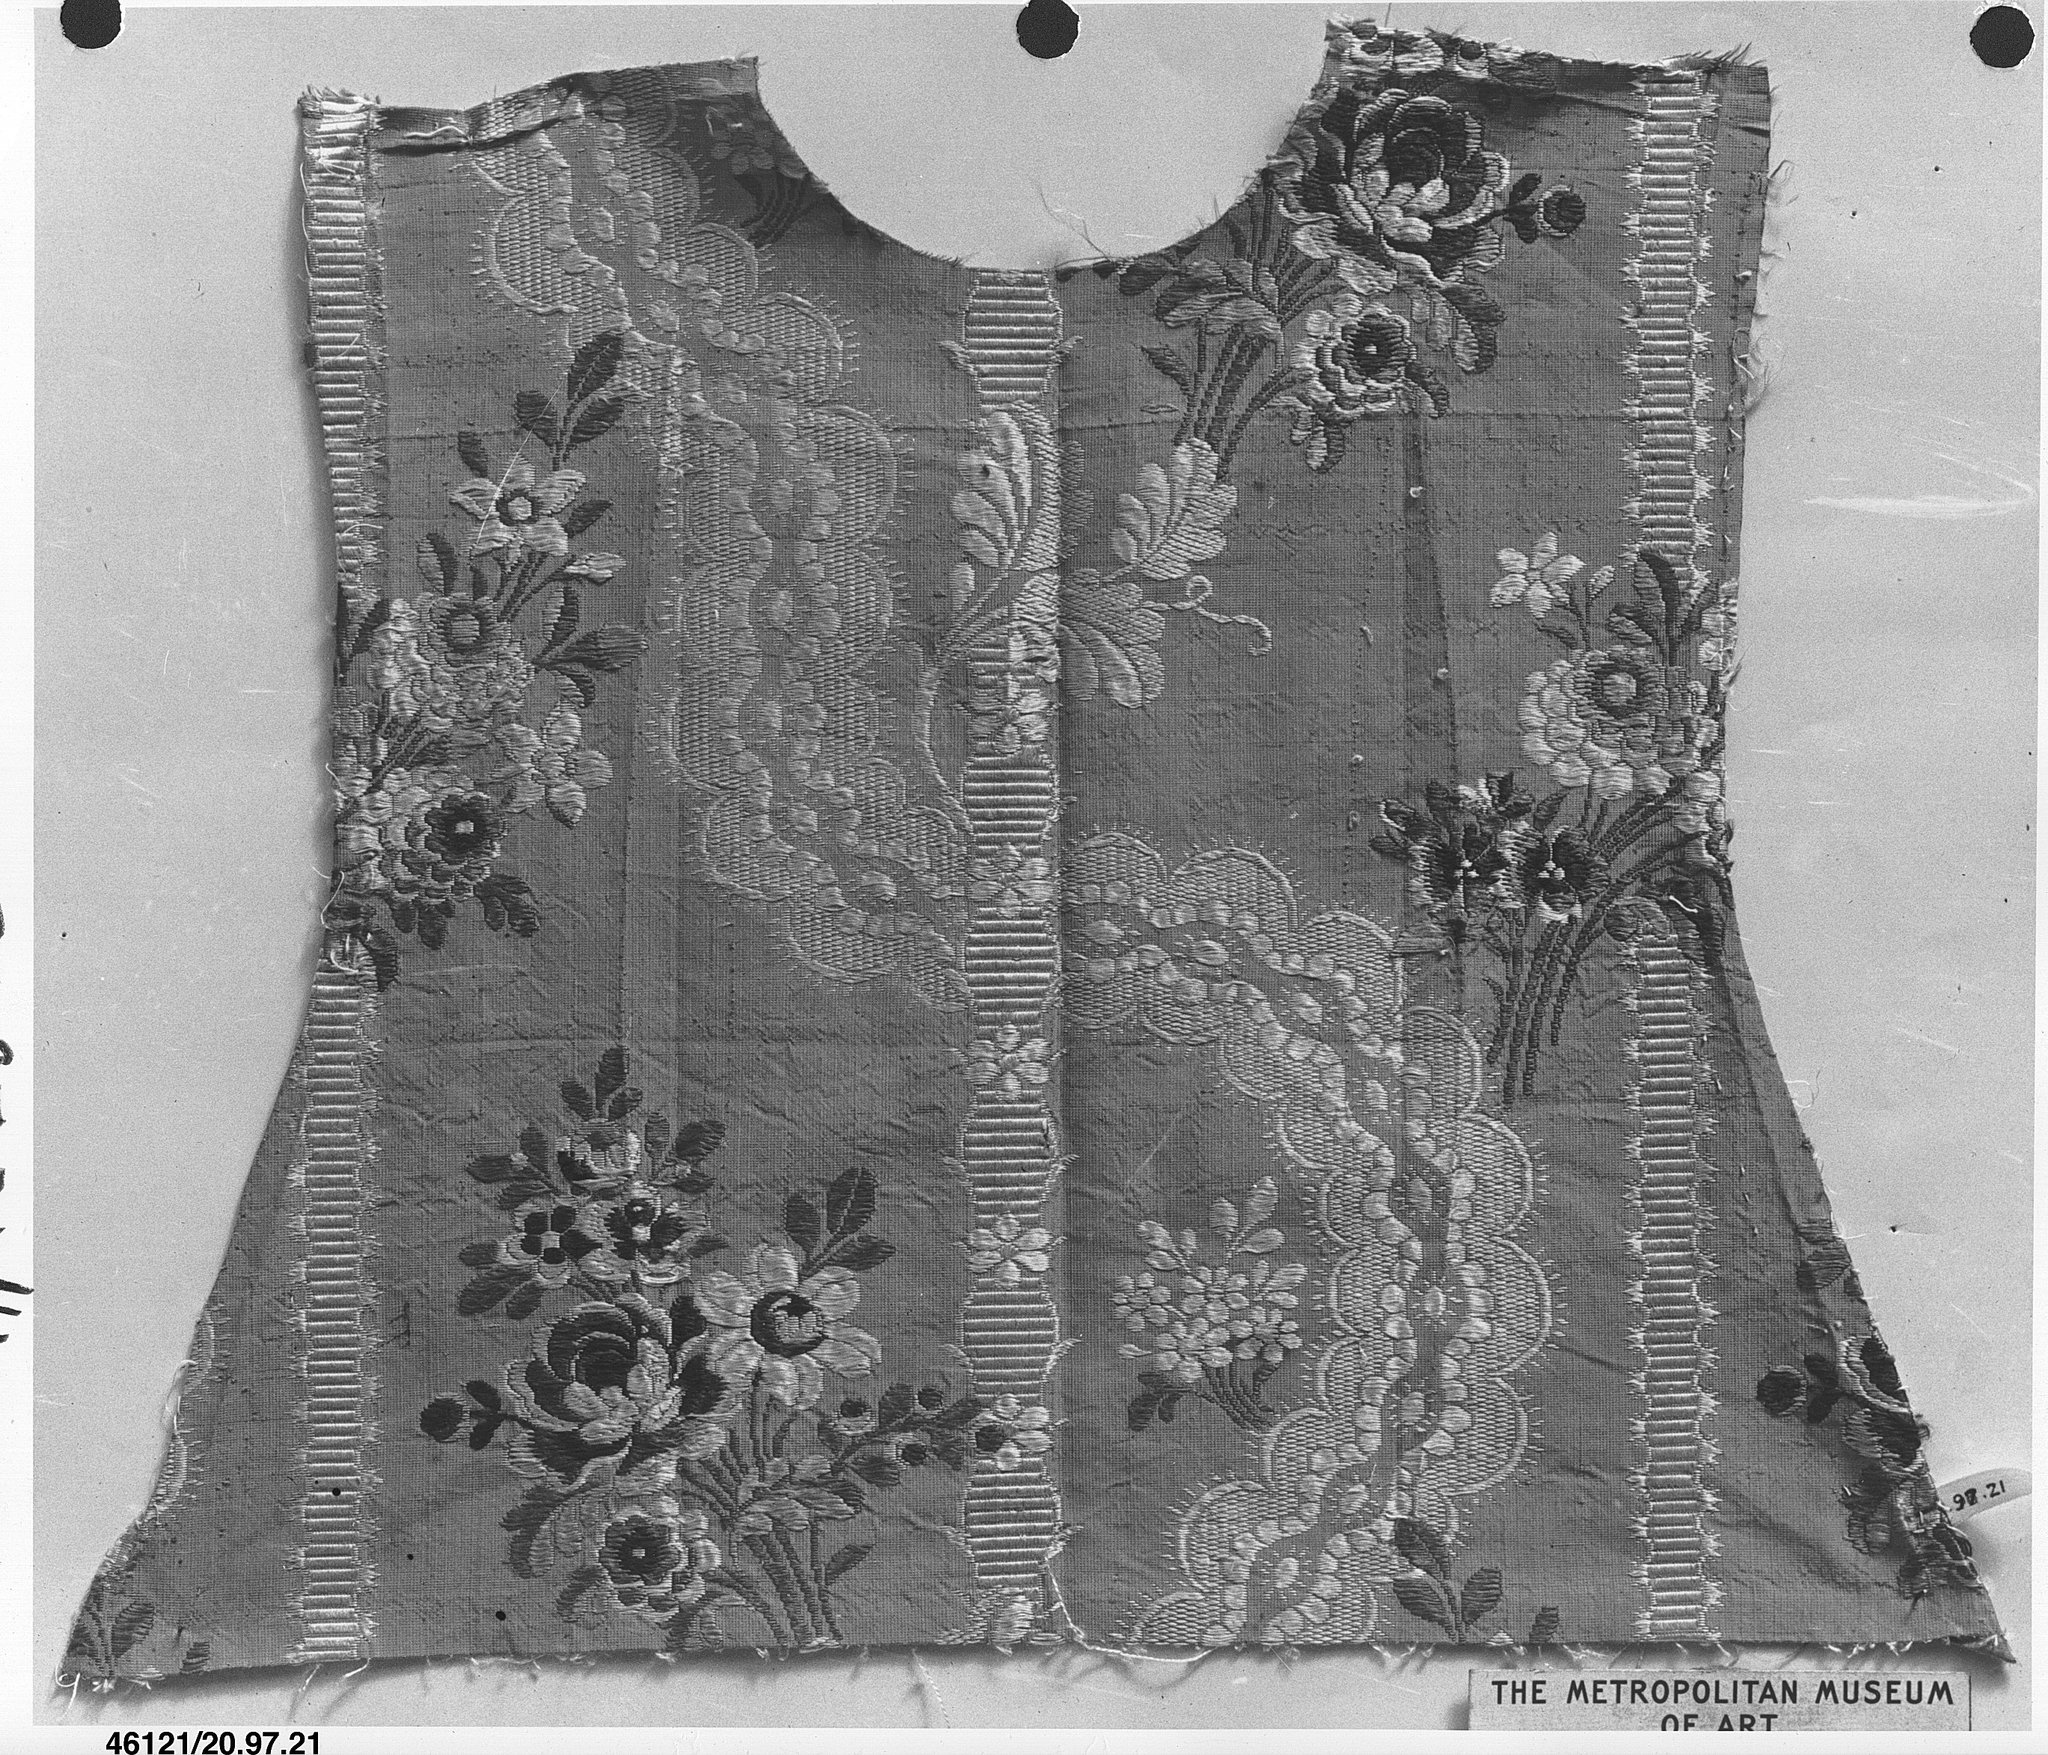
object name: piece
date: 1750-1760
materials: silk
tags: flowers,leaves